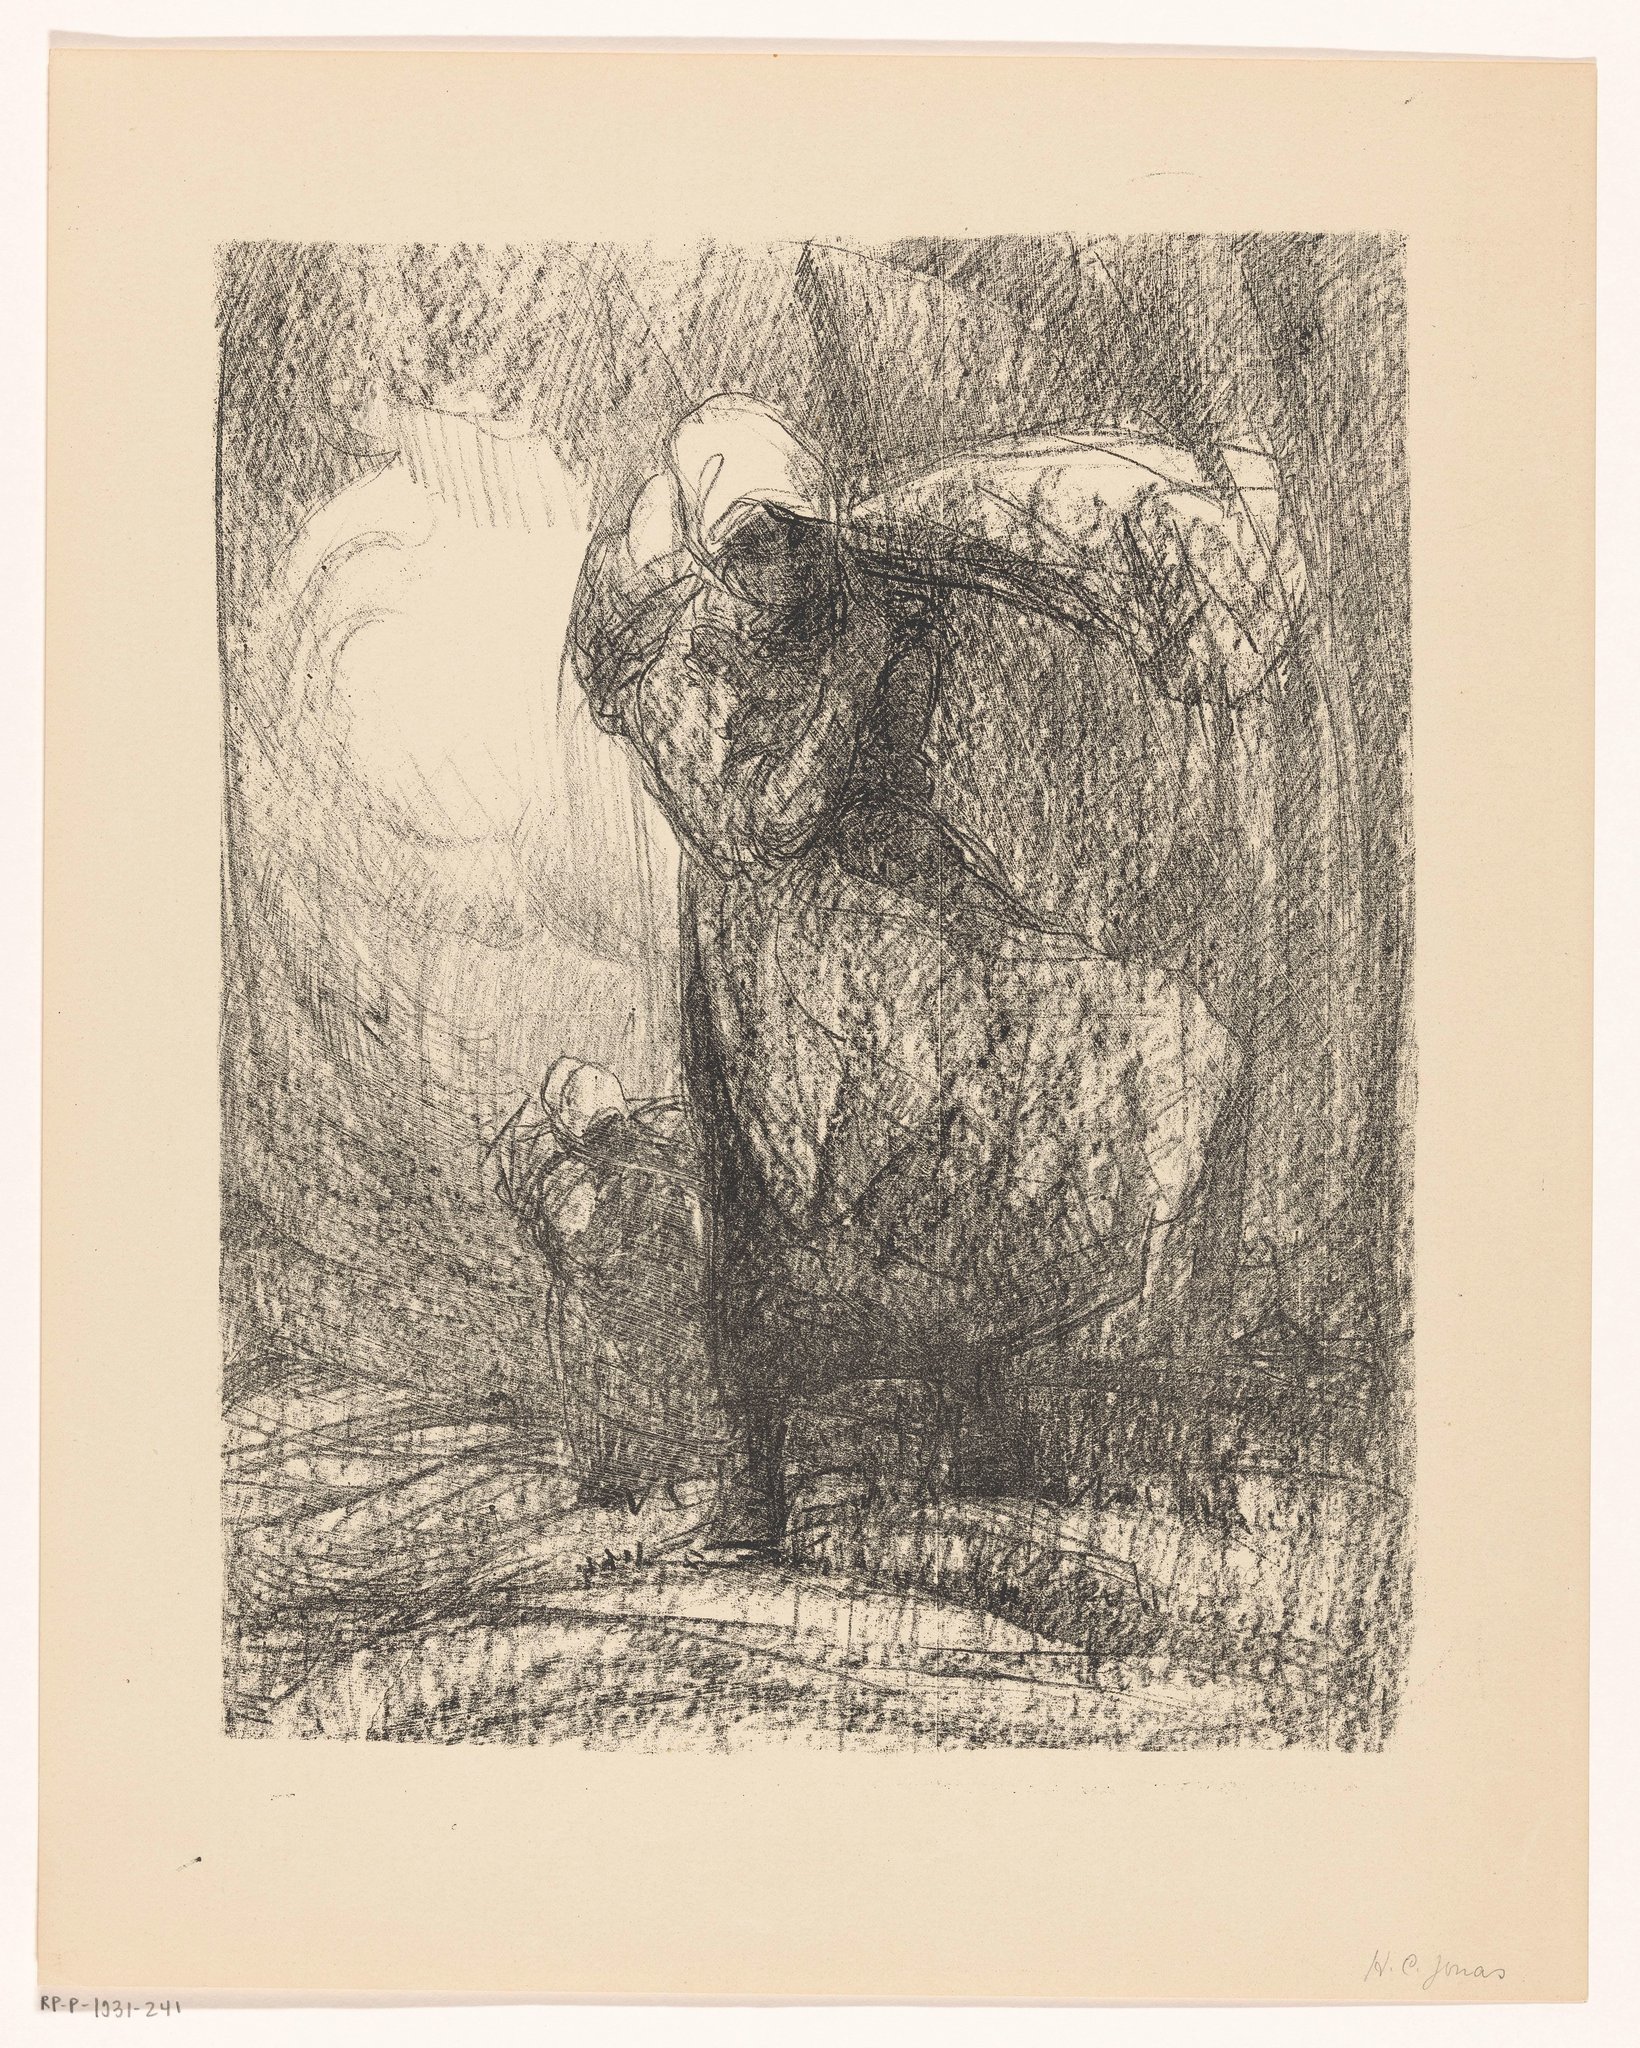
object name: print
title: Twee vrouwen die een last op hun schouders dragen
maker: henri jonas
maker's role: draughtsman, print maker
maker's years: 1878-1944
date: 1888-1931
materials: paper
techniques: lithograph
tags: carrying something on the head or on the shoulders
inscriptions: collector's mark: Lugt 2228